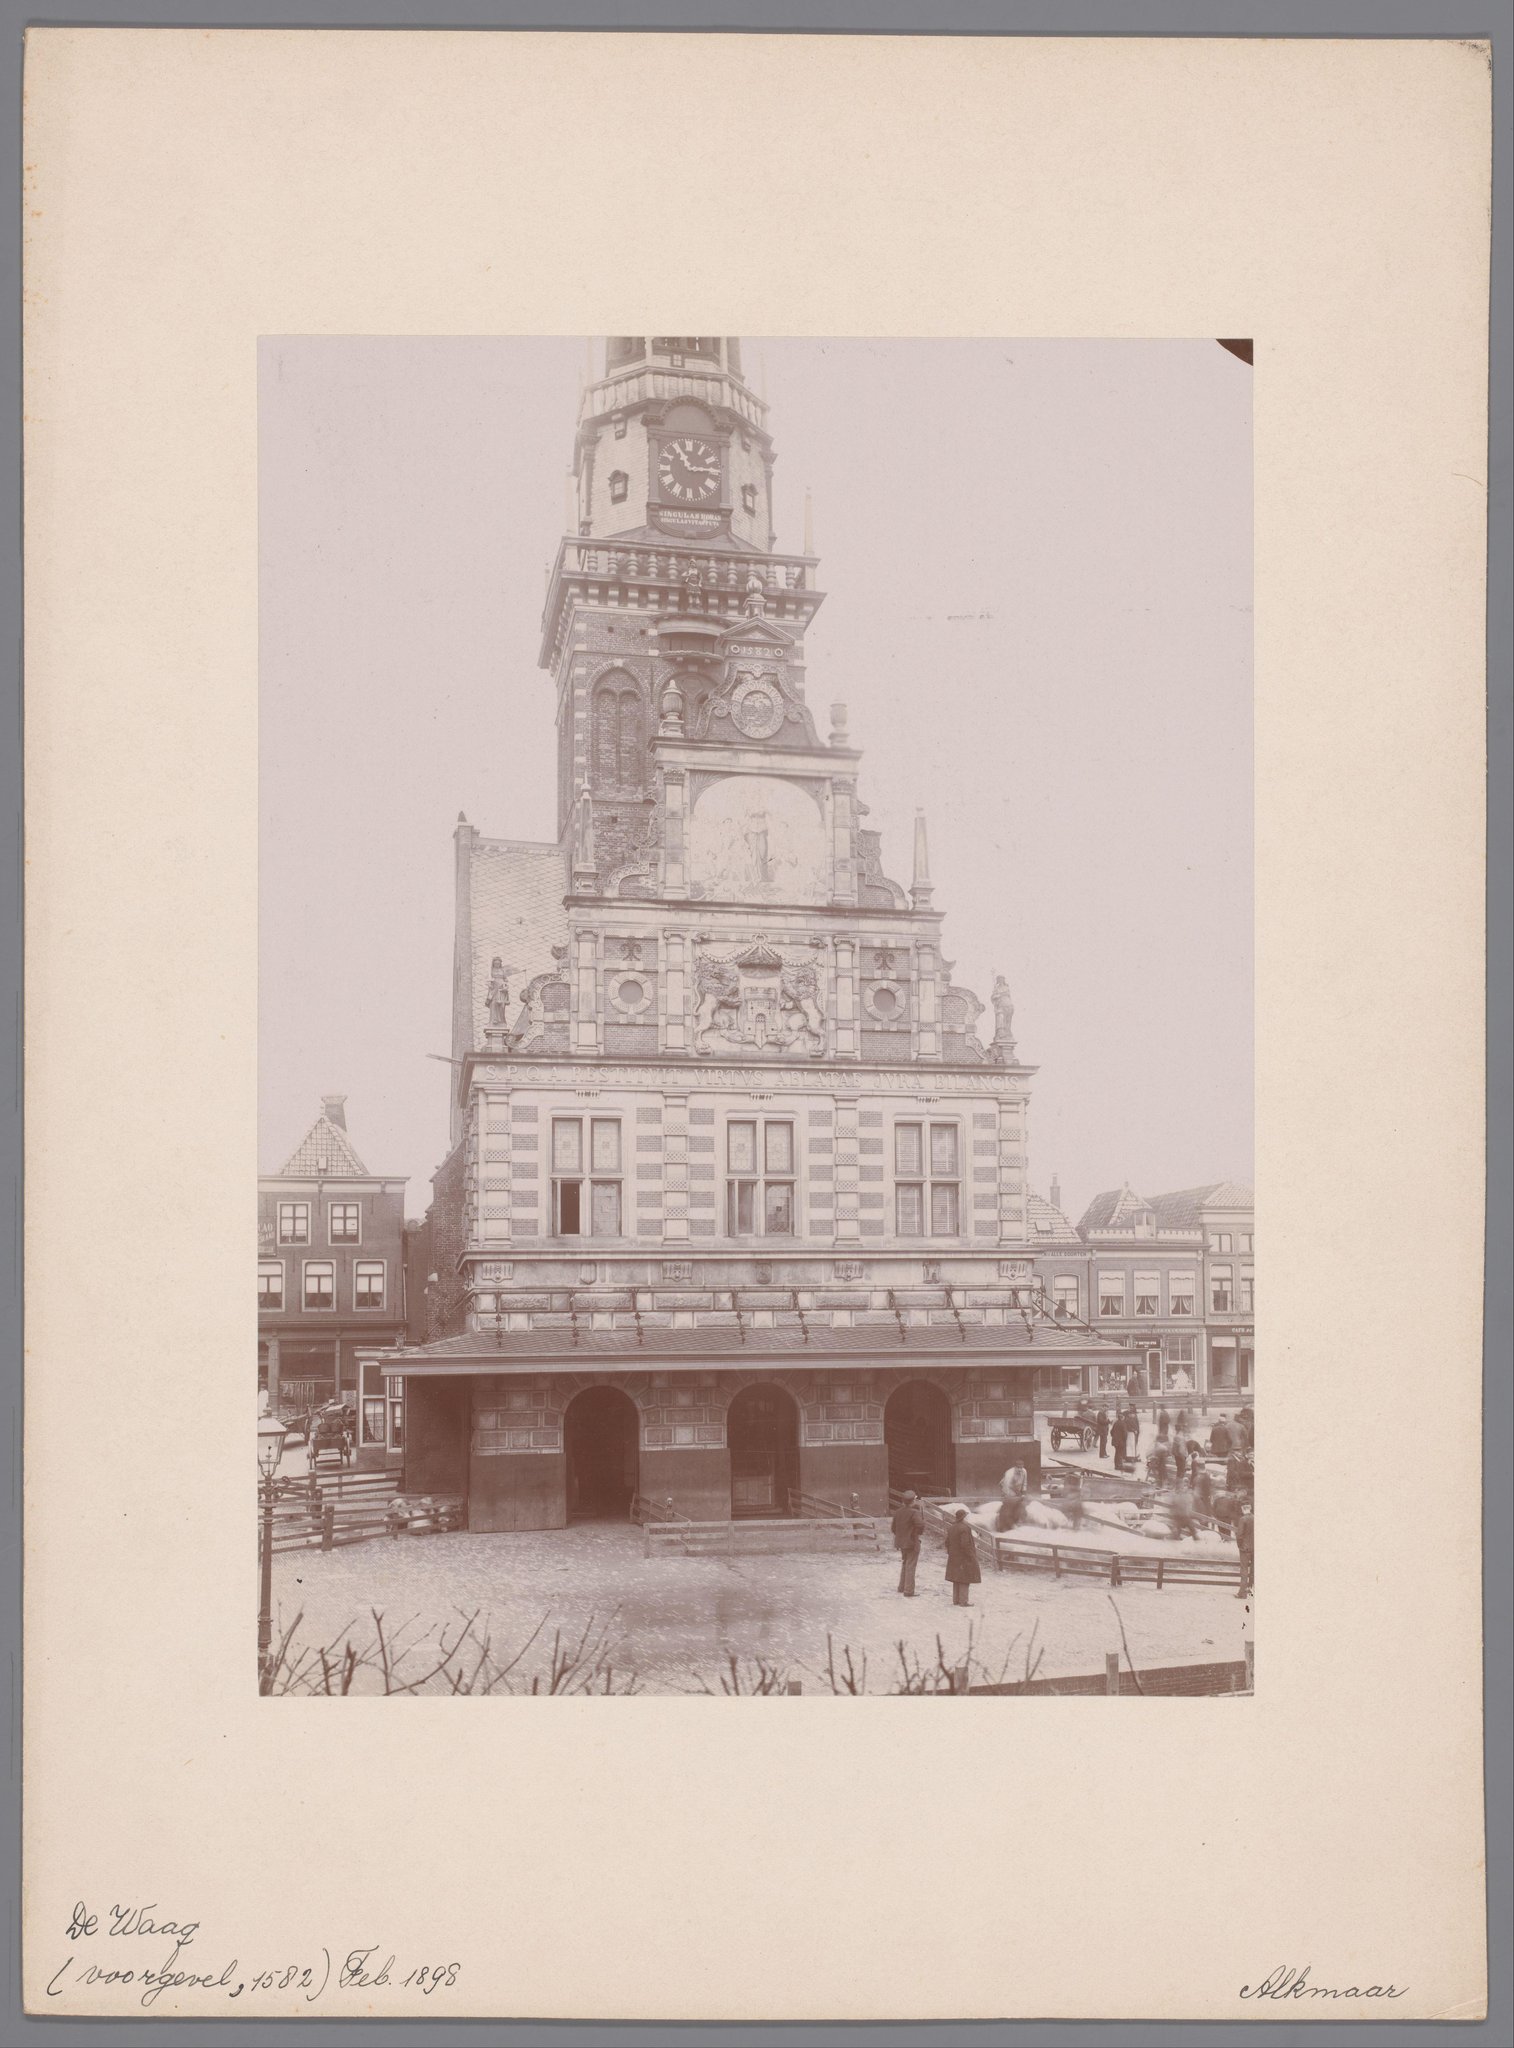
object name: photograph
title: Gezicht op de Waag te Alkmaar met markt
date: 1898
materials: cardboard, photographic support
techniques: gelatin silver print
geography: alkmaar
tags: market, weigh-house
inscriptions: annotation: ‘Alkmaar (N.H.)/ Voorgevel der Waag (1582)/ feb 1898’, annotation: ‘De Waag/ (voorgevel, 1582) Feb. 1898/ Alkmaar’